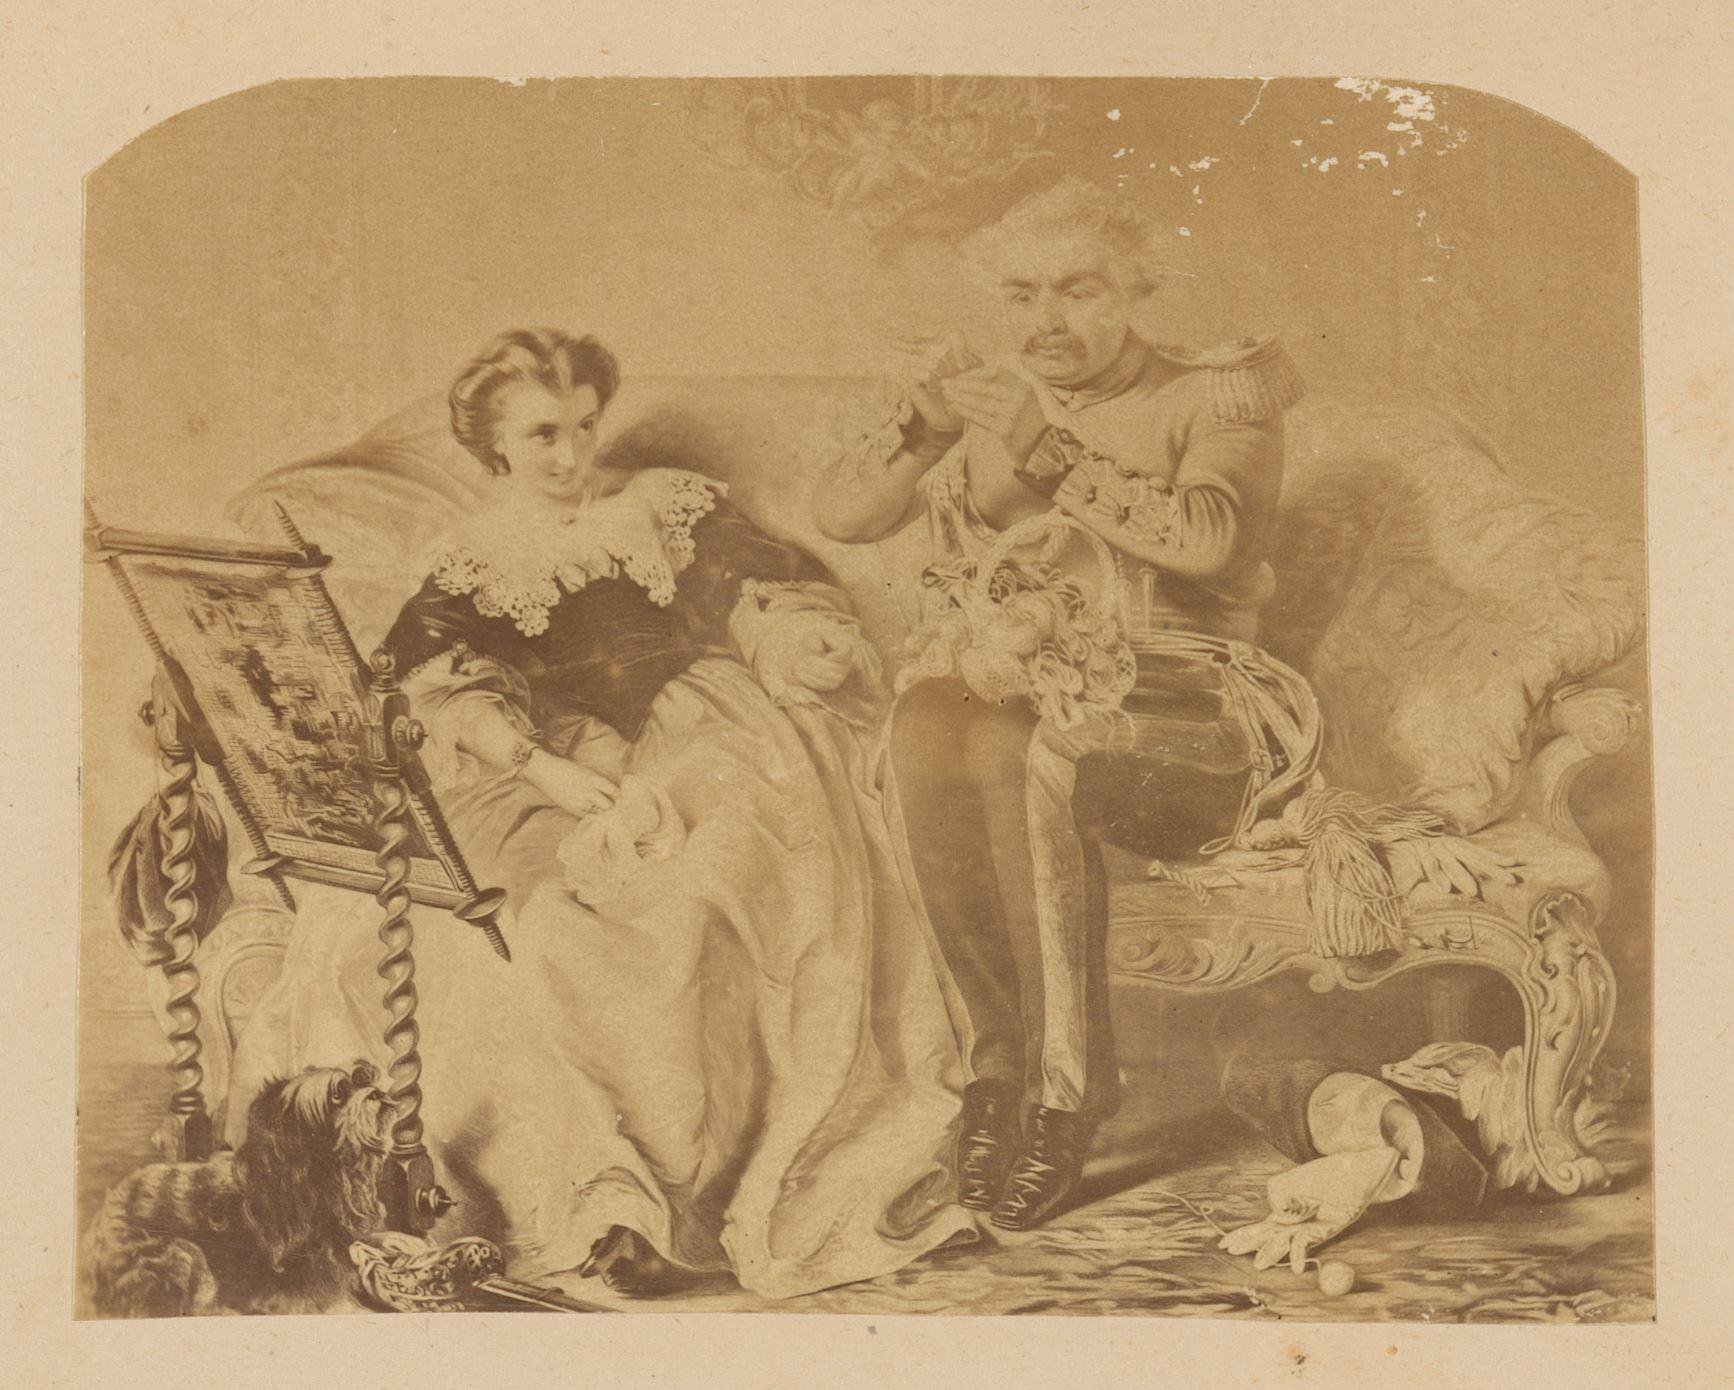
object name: photograph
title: Fotoreproductie van een schilderij van een man in militair uniform met naald en draad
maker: Anonymous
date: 1875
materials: paper, photographic support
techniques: albumen print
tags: needle ~ sewing, (military) uniforms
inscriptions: annotation: ‘The lion in love’